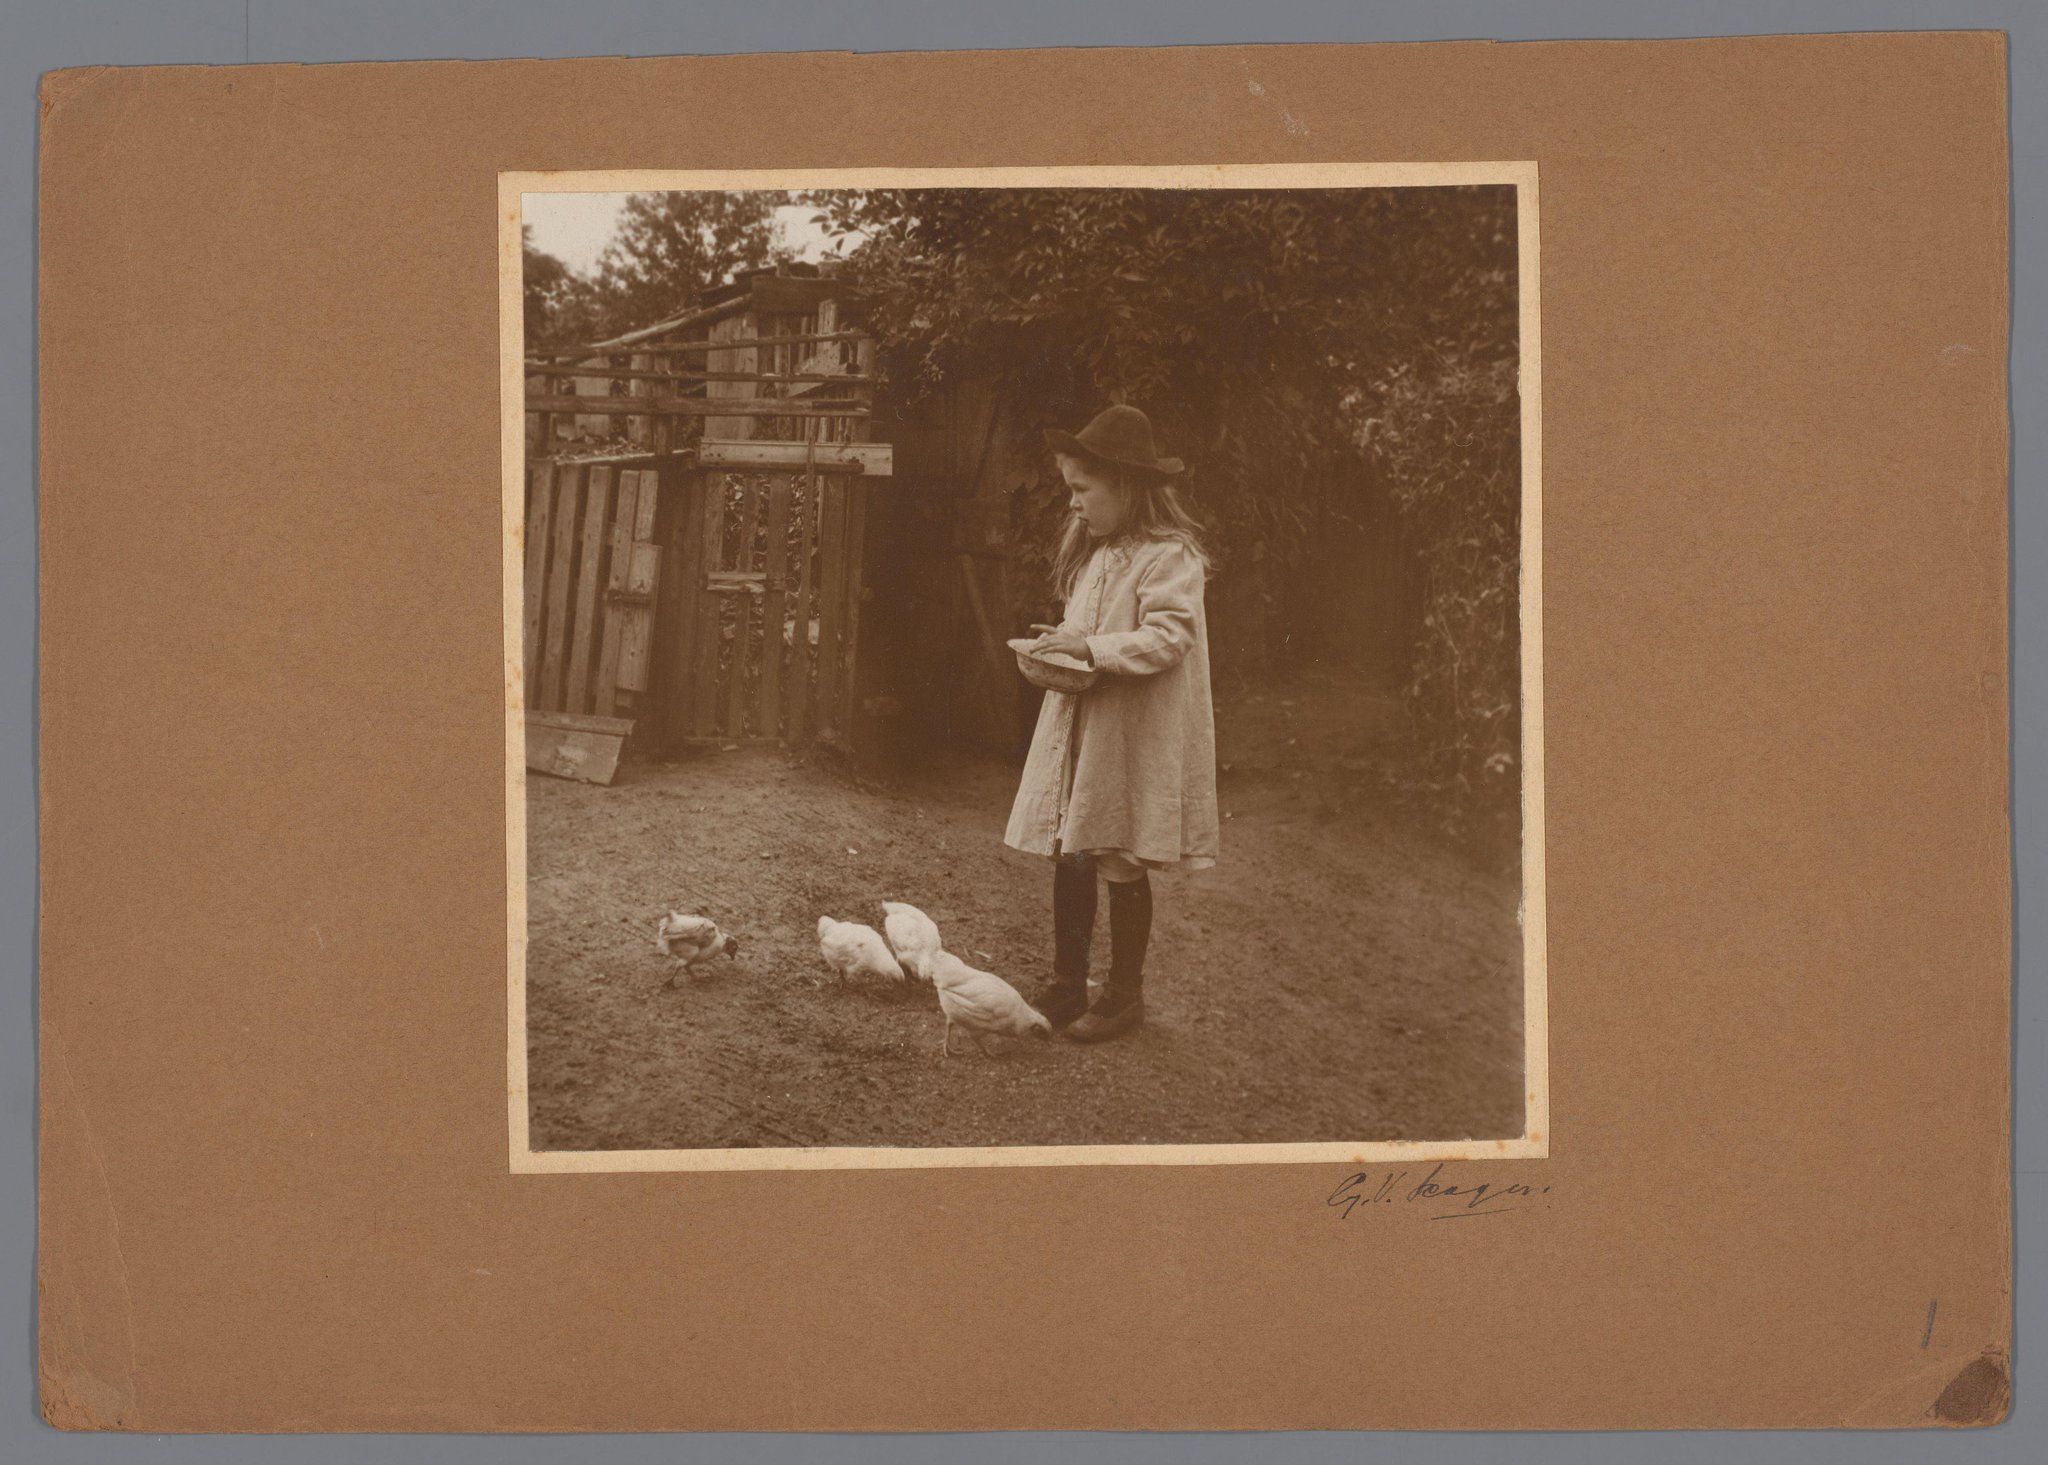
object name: photograph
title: Meisje dat kippen voert in een tuin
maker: g.v. scagen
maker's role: fotograaf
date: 1900-1930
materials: cardboard, photographic support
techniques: gelatin silver print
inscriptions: signature: ‘G.V. Scagen (?)’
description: Portret van een meisje met lange jas en hoed, kippen voerend in een tuin.